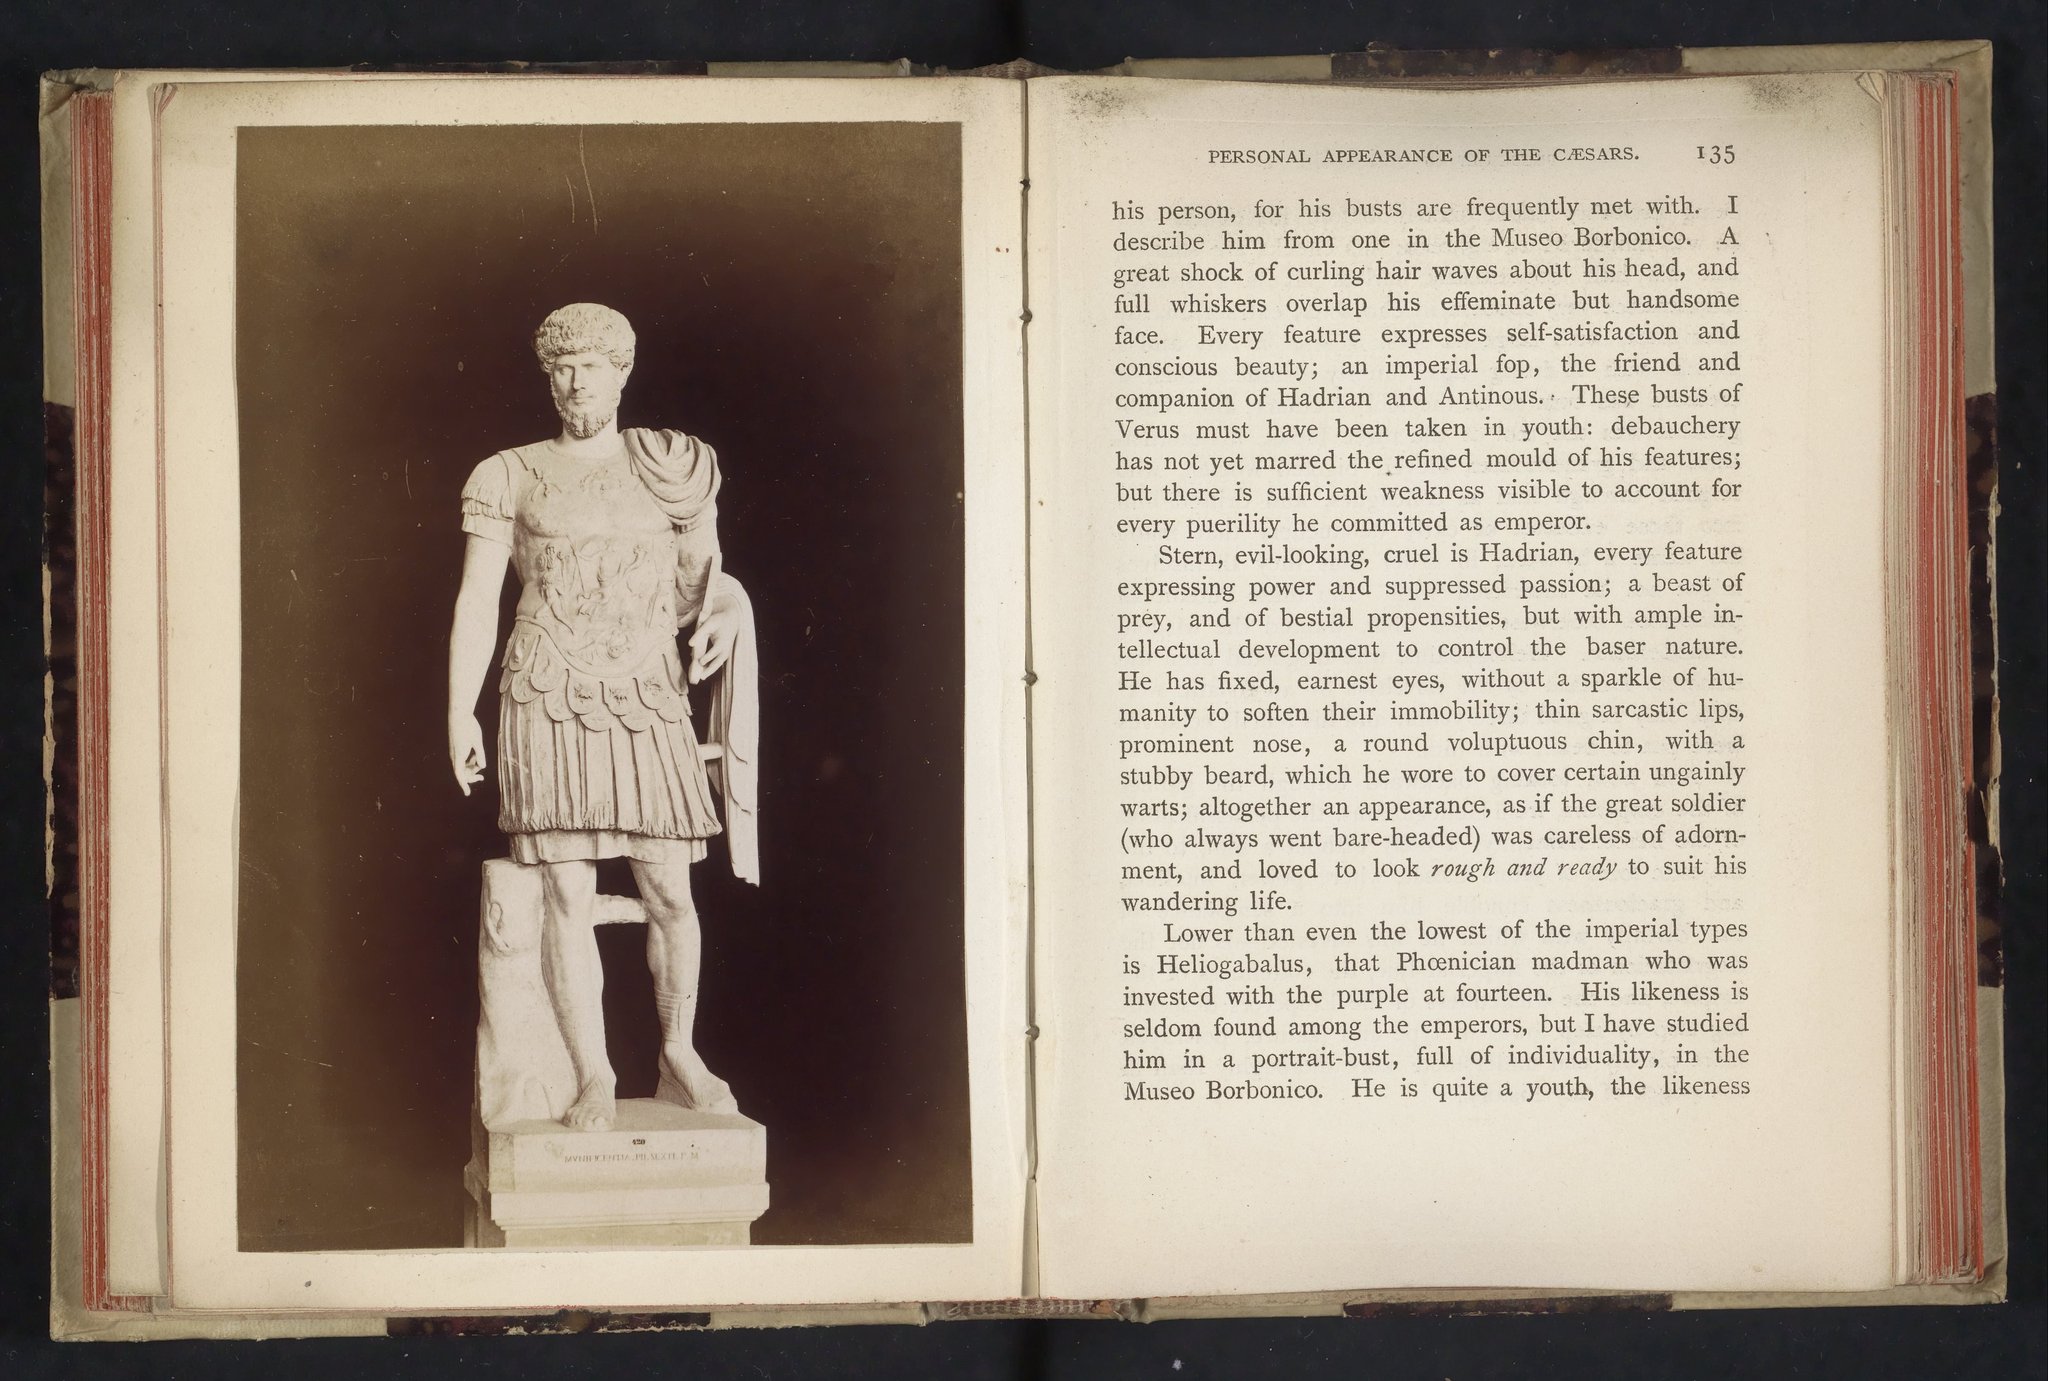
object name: page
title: Sculptuur van keizer Lucius Verus in de Vaticaanse Musea te Vaticaanstad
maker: Anonymous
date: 1872-1882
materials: photographic support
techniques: albumen print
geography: vatican museums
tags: emperor, sculpture